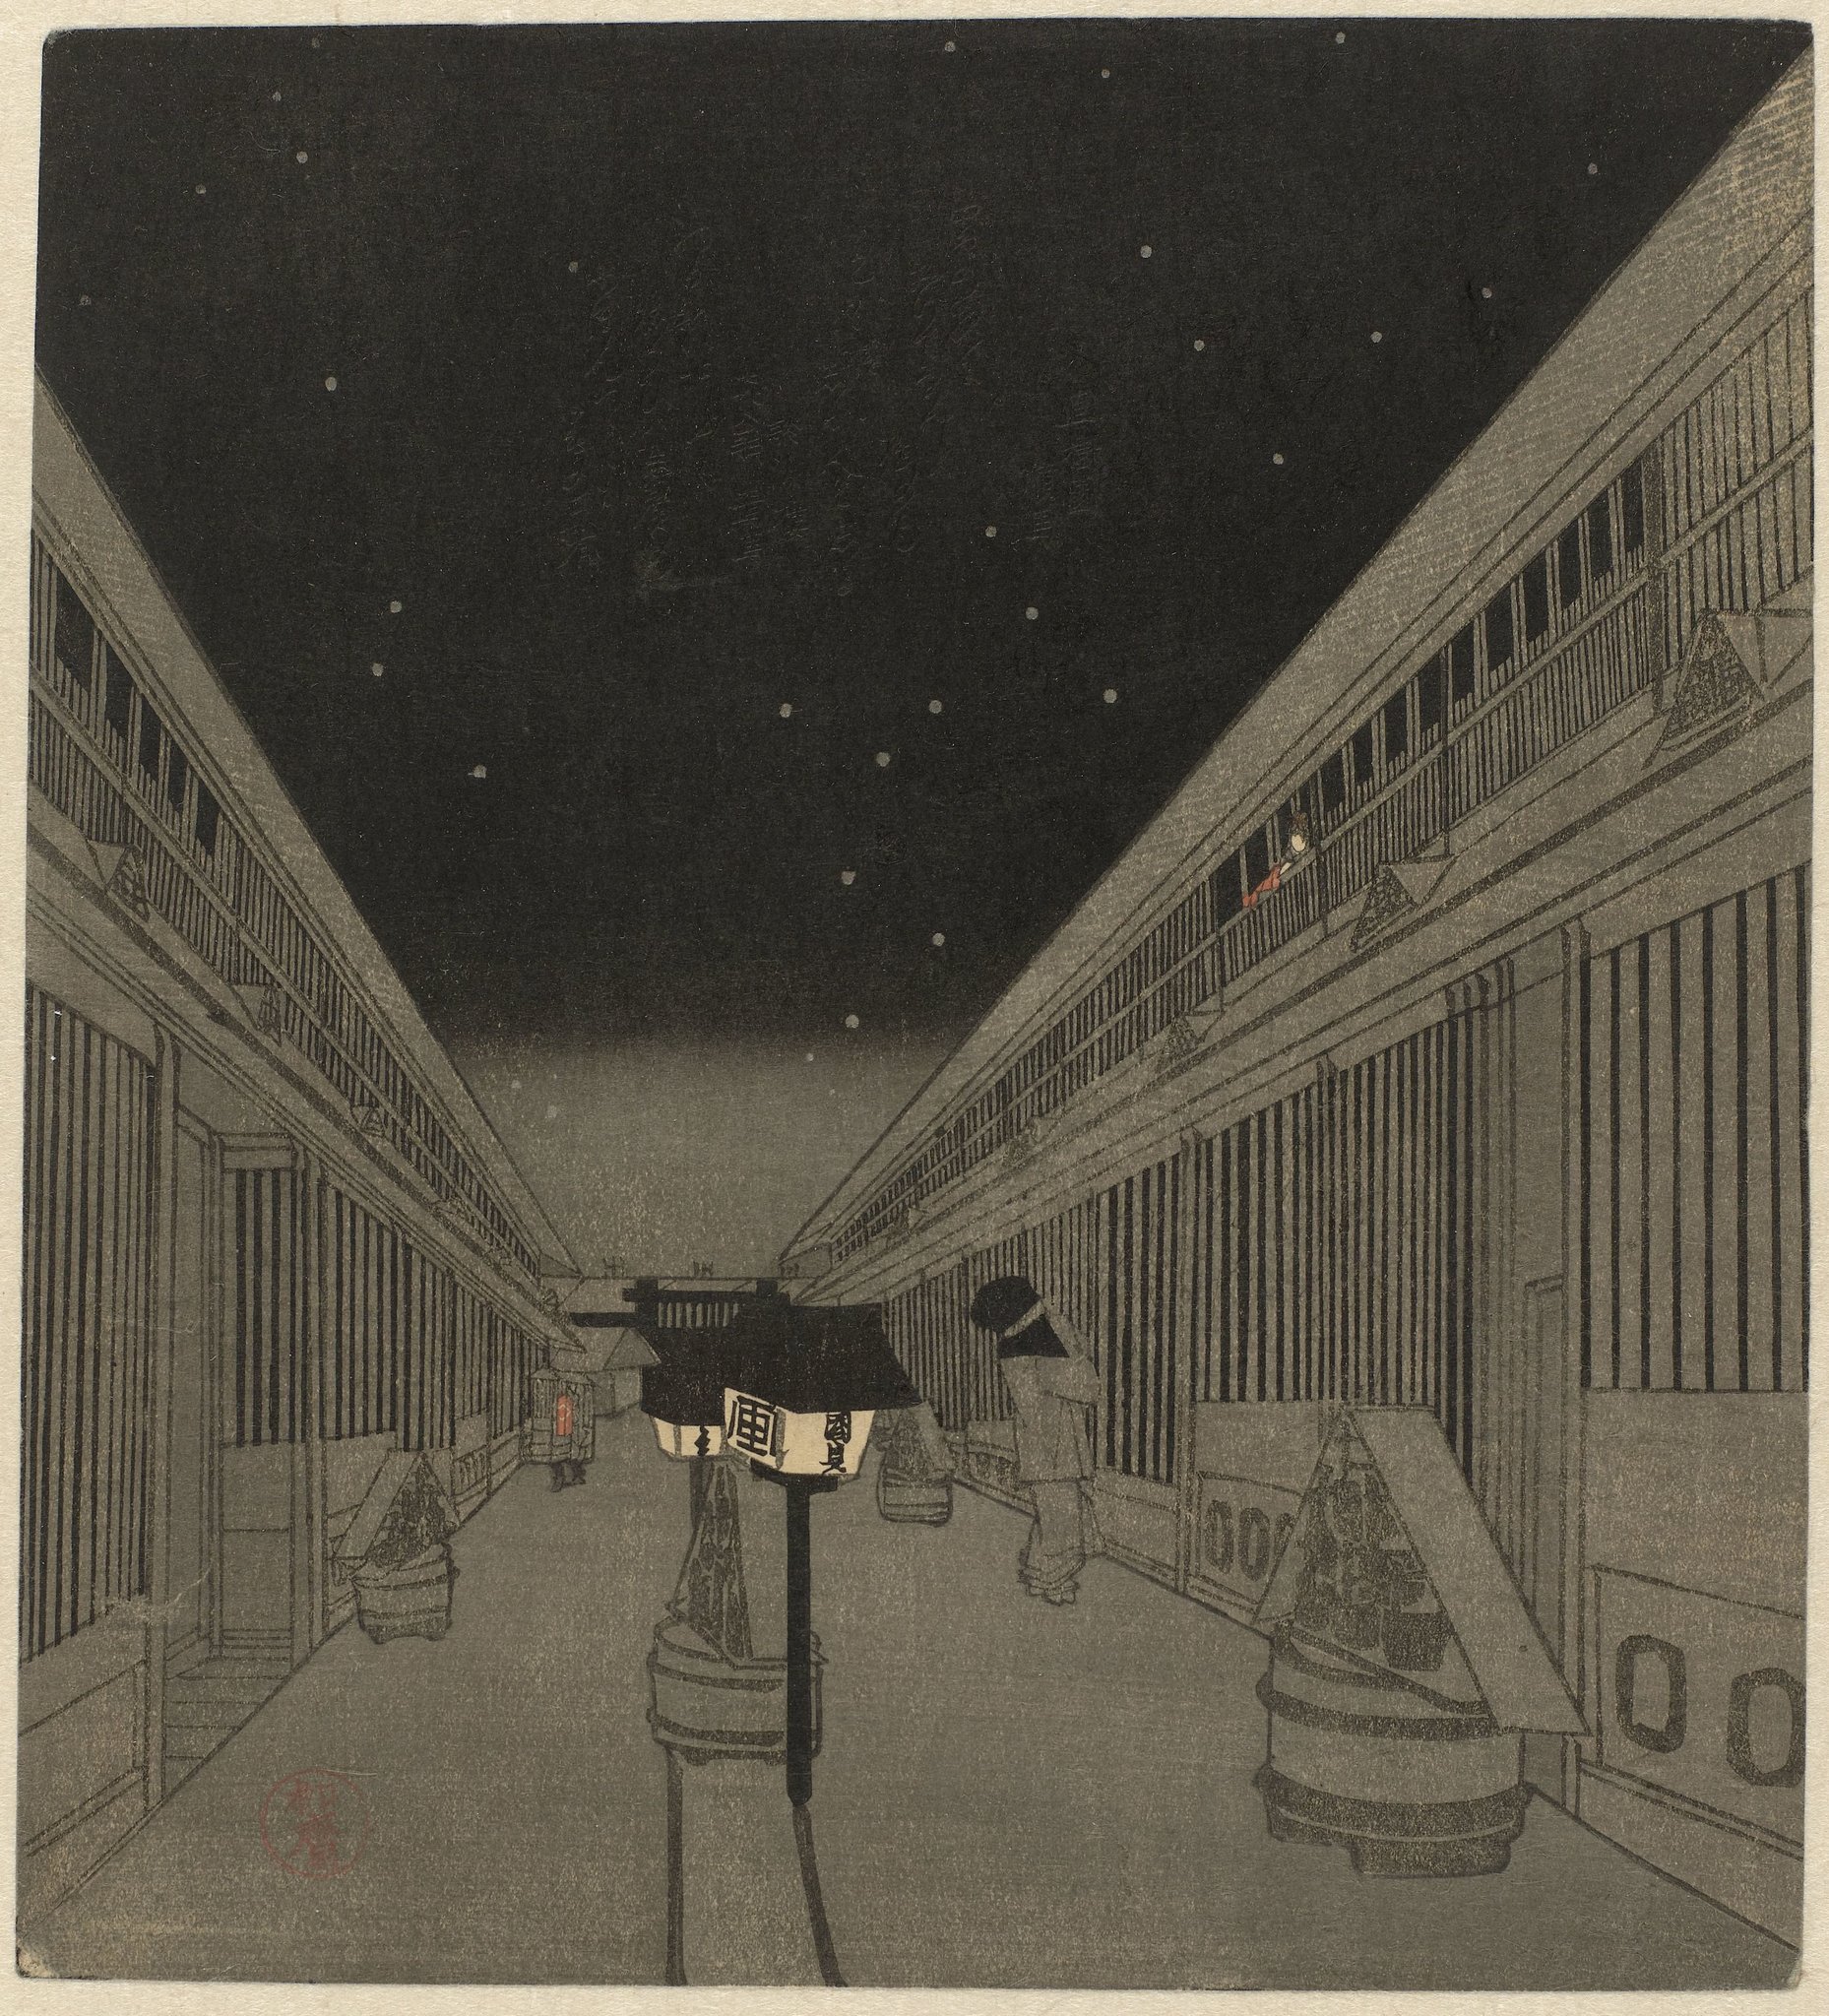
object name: surimono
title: Yoshiwara bij nacht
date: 1852-1864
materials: paper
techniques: woodcut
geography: japan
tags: courtesan, hetaera, night, street (+ city(-scape) with figures, staffage)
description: Een surimono is een luxe uitgevoerde prent waarop beeld met één of meerdere gedichten gecombineerd is. Bij het drukken van een surimono werd vaak gebruik gemaakt van dikker papier, blinddruk en metaal pigmenten, zoals koper- en zilverpoeder. De prenten werden vaak in opdracht van dichters gemaakt en als exclusief geschenk aan vrienden en relaties gegeven.